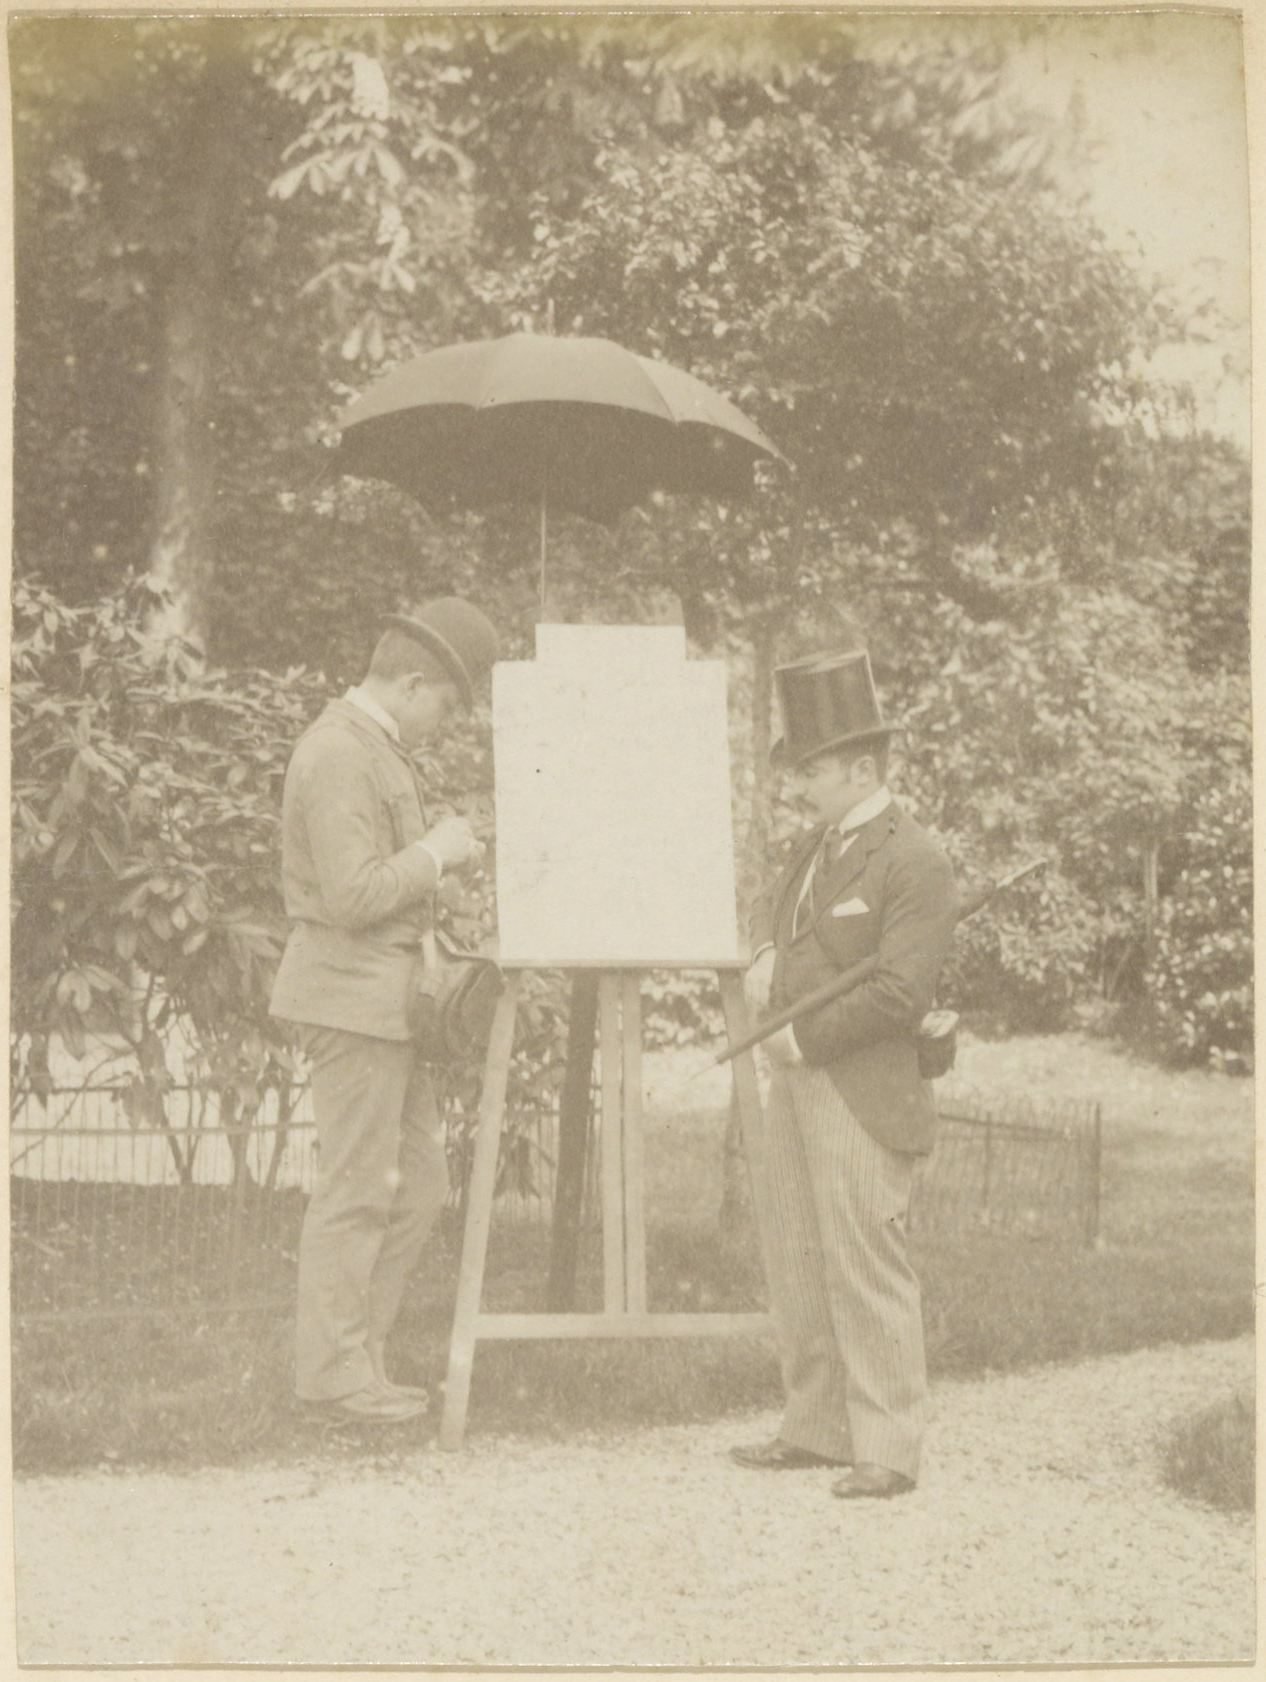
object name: photograph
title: Twee Franse mannen staand bij een schildersezel in een tuin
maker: Anonymous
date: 1900-1910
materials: paper, photographic support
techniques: albumen print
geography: france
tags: head-gear: bowler hat, adult man, umbrella, easel, head-gear: top hat, france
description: Onderdeel van Fotoalbum van een Franse amateurfotograaf met opnames van een familie, distilleerderij Delizy & Doistau Fils, het leger en bezienswaardigheden in Frankrijk.